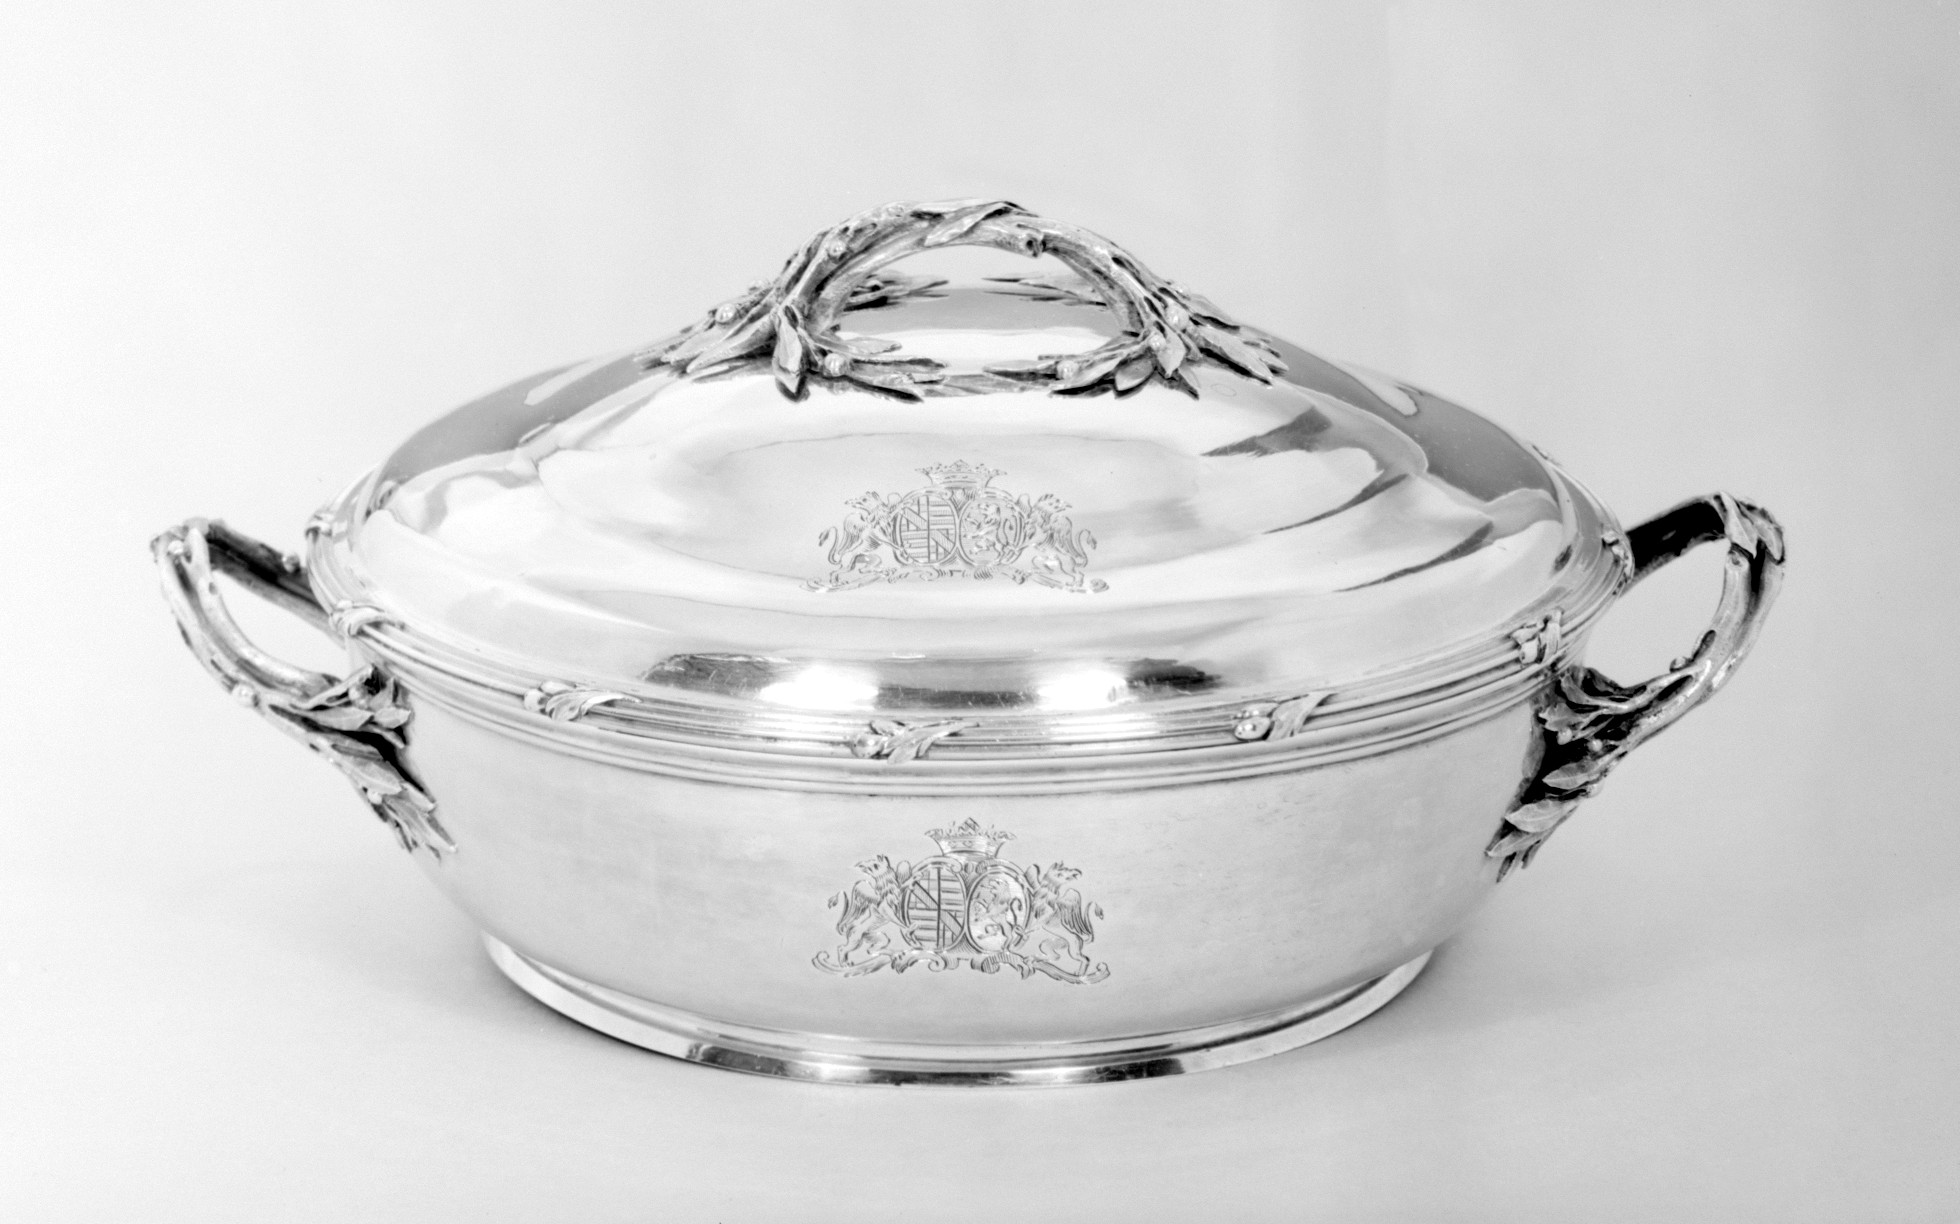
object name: dish with cover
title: Dish with cover (one of a pair)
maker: charles-louis-auguste spriman (or spriment)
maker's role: maker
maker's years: 1745-1825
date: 1778-1779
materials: silver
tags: coat of arms